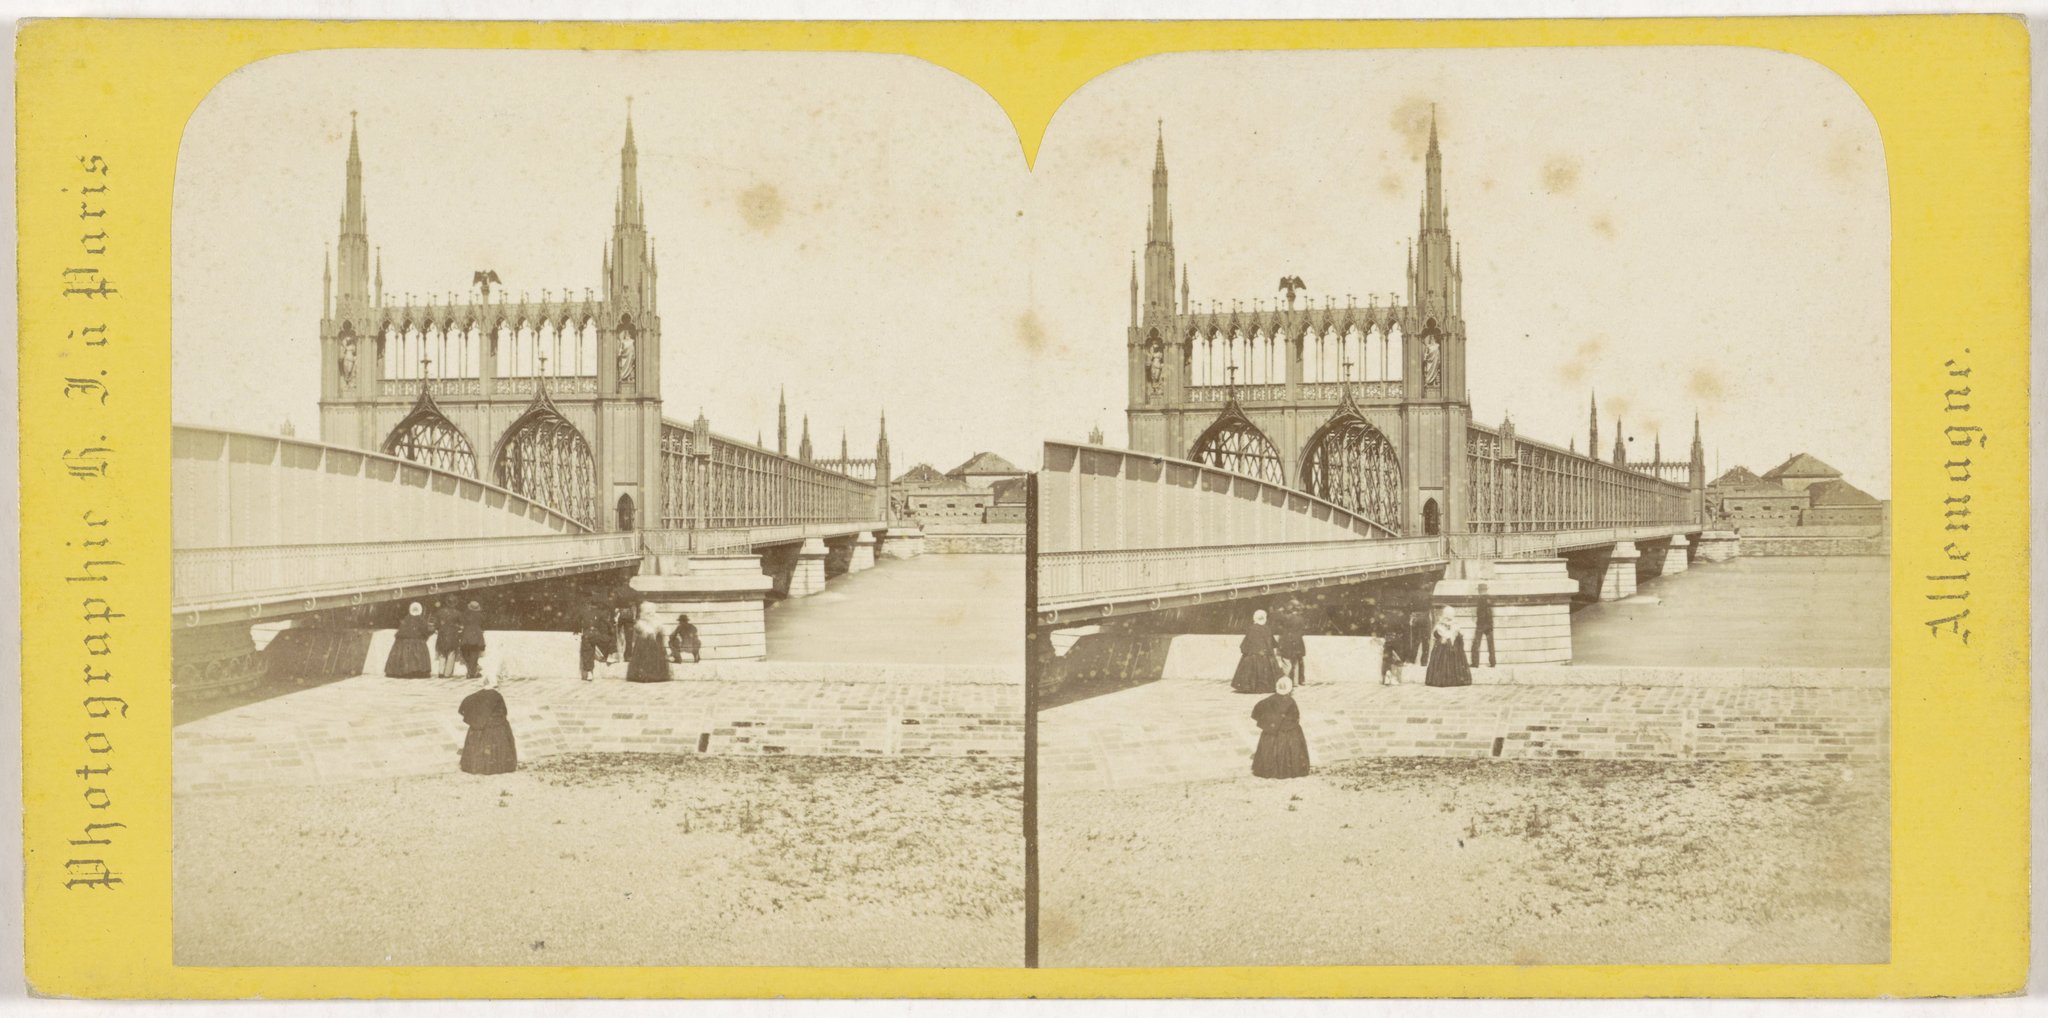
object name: stereograph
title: Spoorbrug over de Rijn tussen Kehl en Straatsburg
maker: hippolyte jouvin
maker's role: fotograaf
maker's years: 1825-1889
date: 1860-1870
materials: cardboard, paper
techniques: albumen print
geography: kehl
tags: bridge in city across river, canal, etc.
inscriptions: number: ‘N. 310’, inscription: ‘Déposé.’